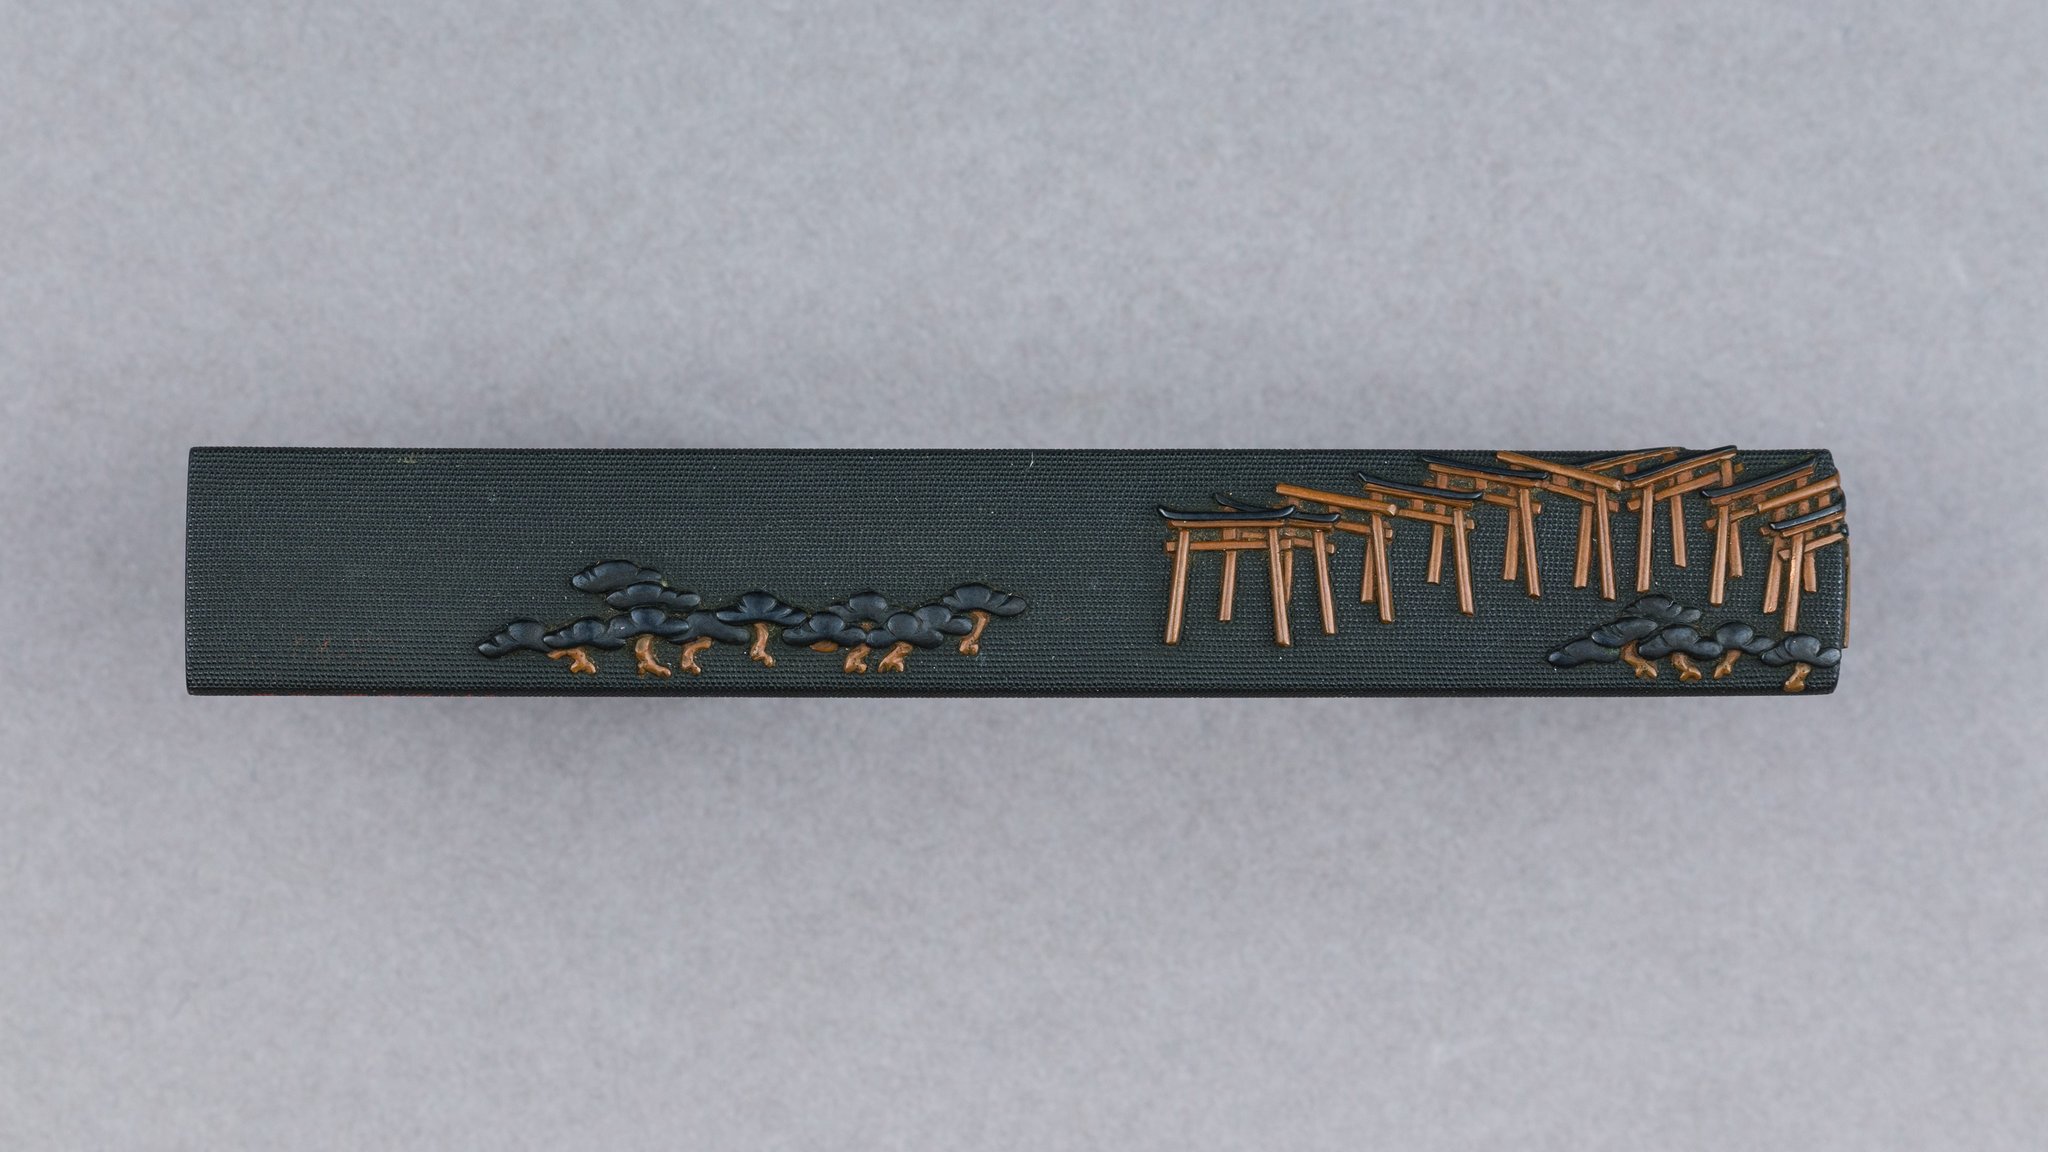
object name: knife handle kozuka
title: Knife Handle (Kozuka)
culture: japanese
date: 1801-1900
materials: copper, gold alloy, silver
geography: japan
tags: gates